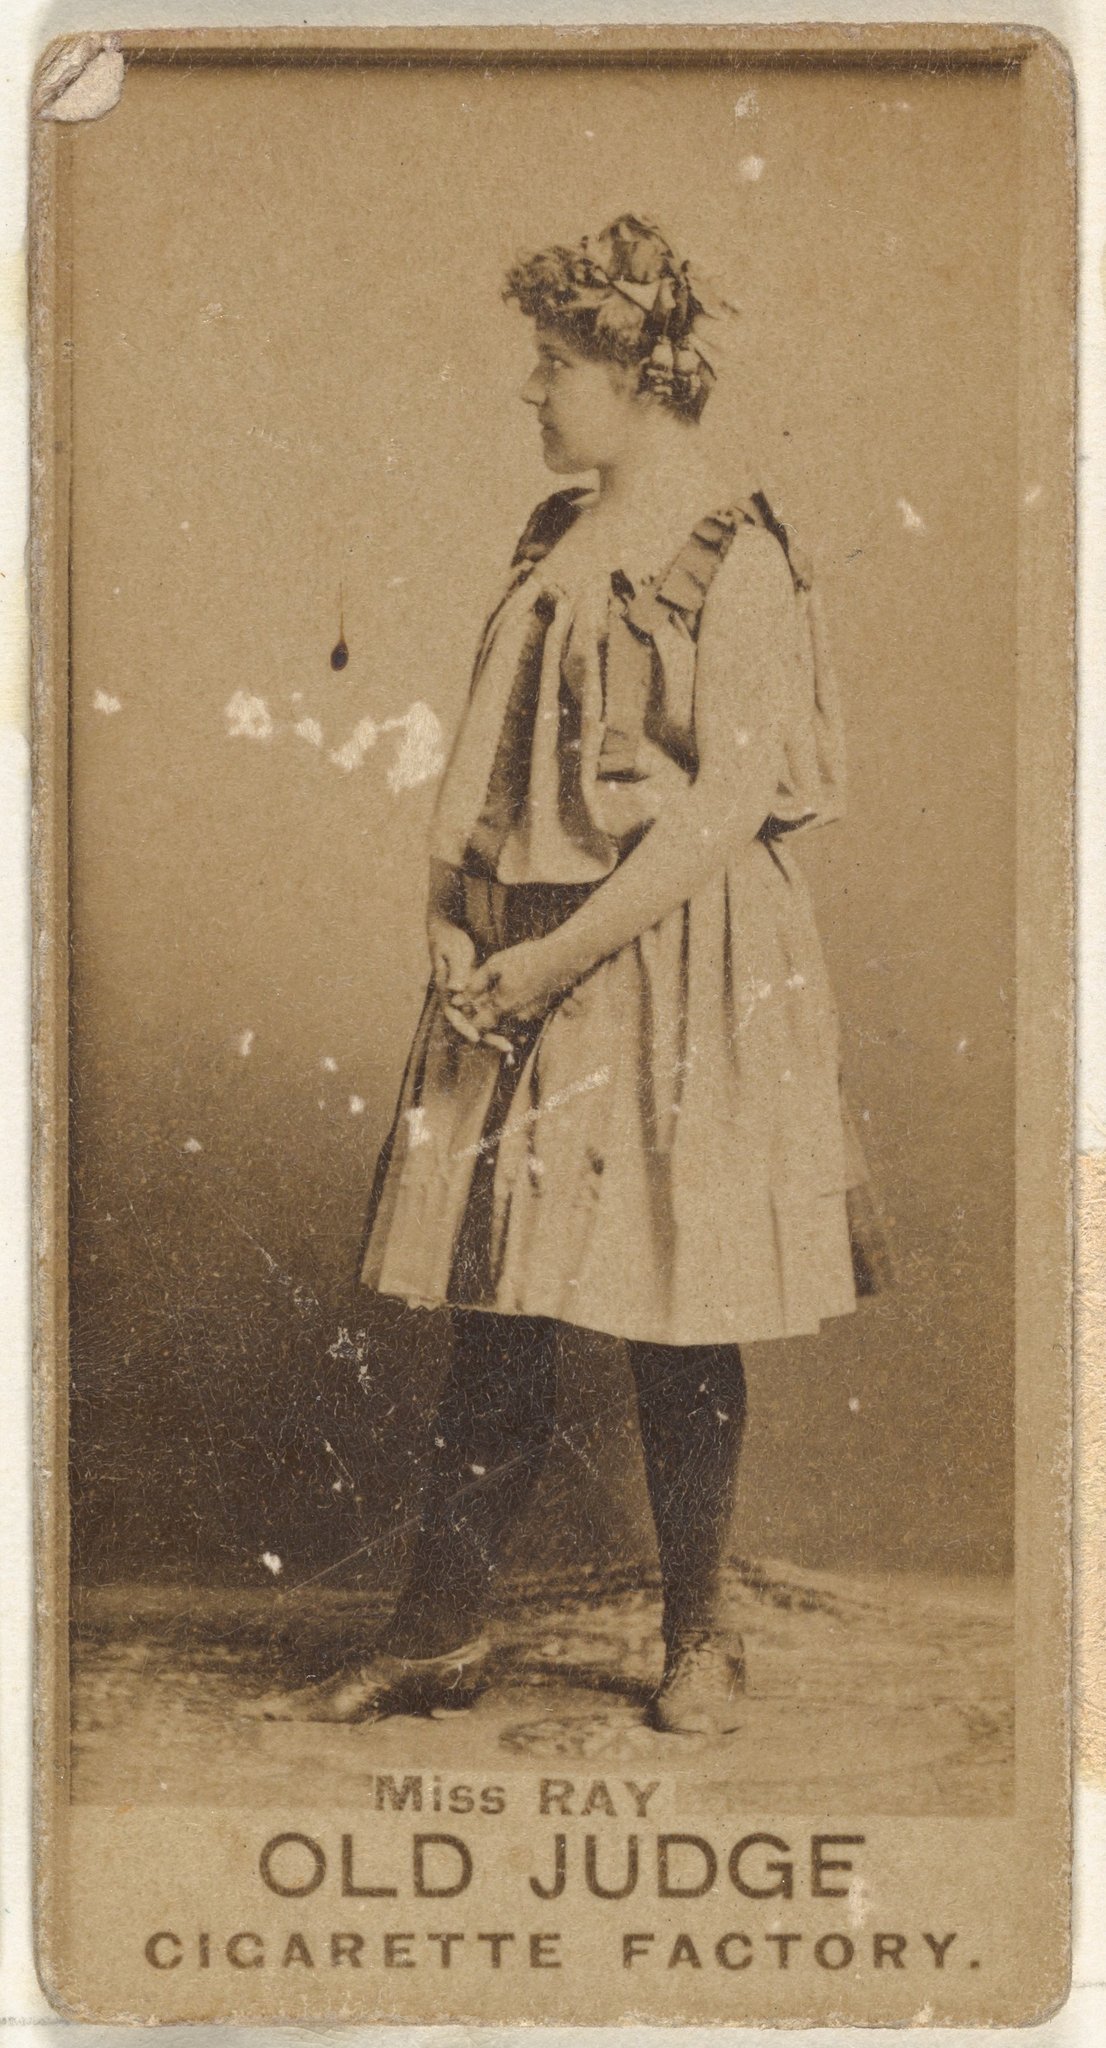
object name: photograph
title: Miss Ray, from the Actors and Actresses series (N171) for Old Judge Cigarettes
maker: goodwin & company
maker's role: publisher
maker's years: 1850-1950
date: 1886-1890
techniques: albumen silver print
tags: portraits,women,actresses